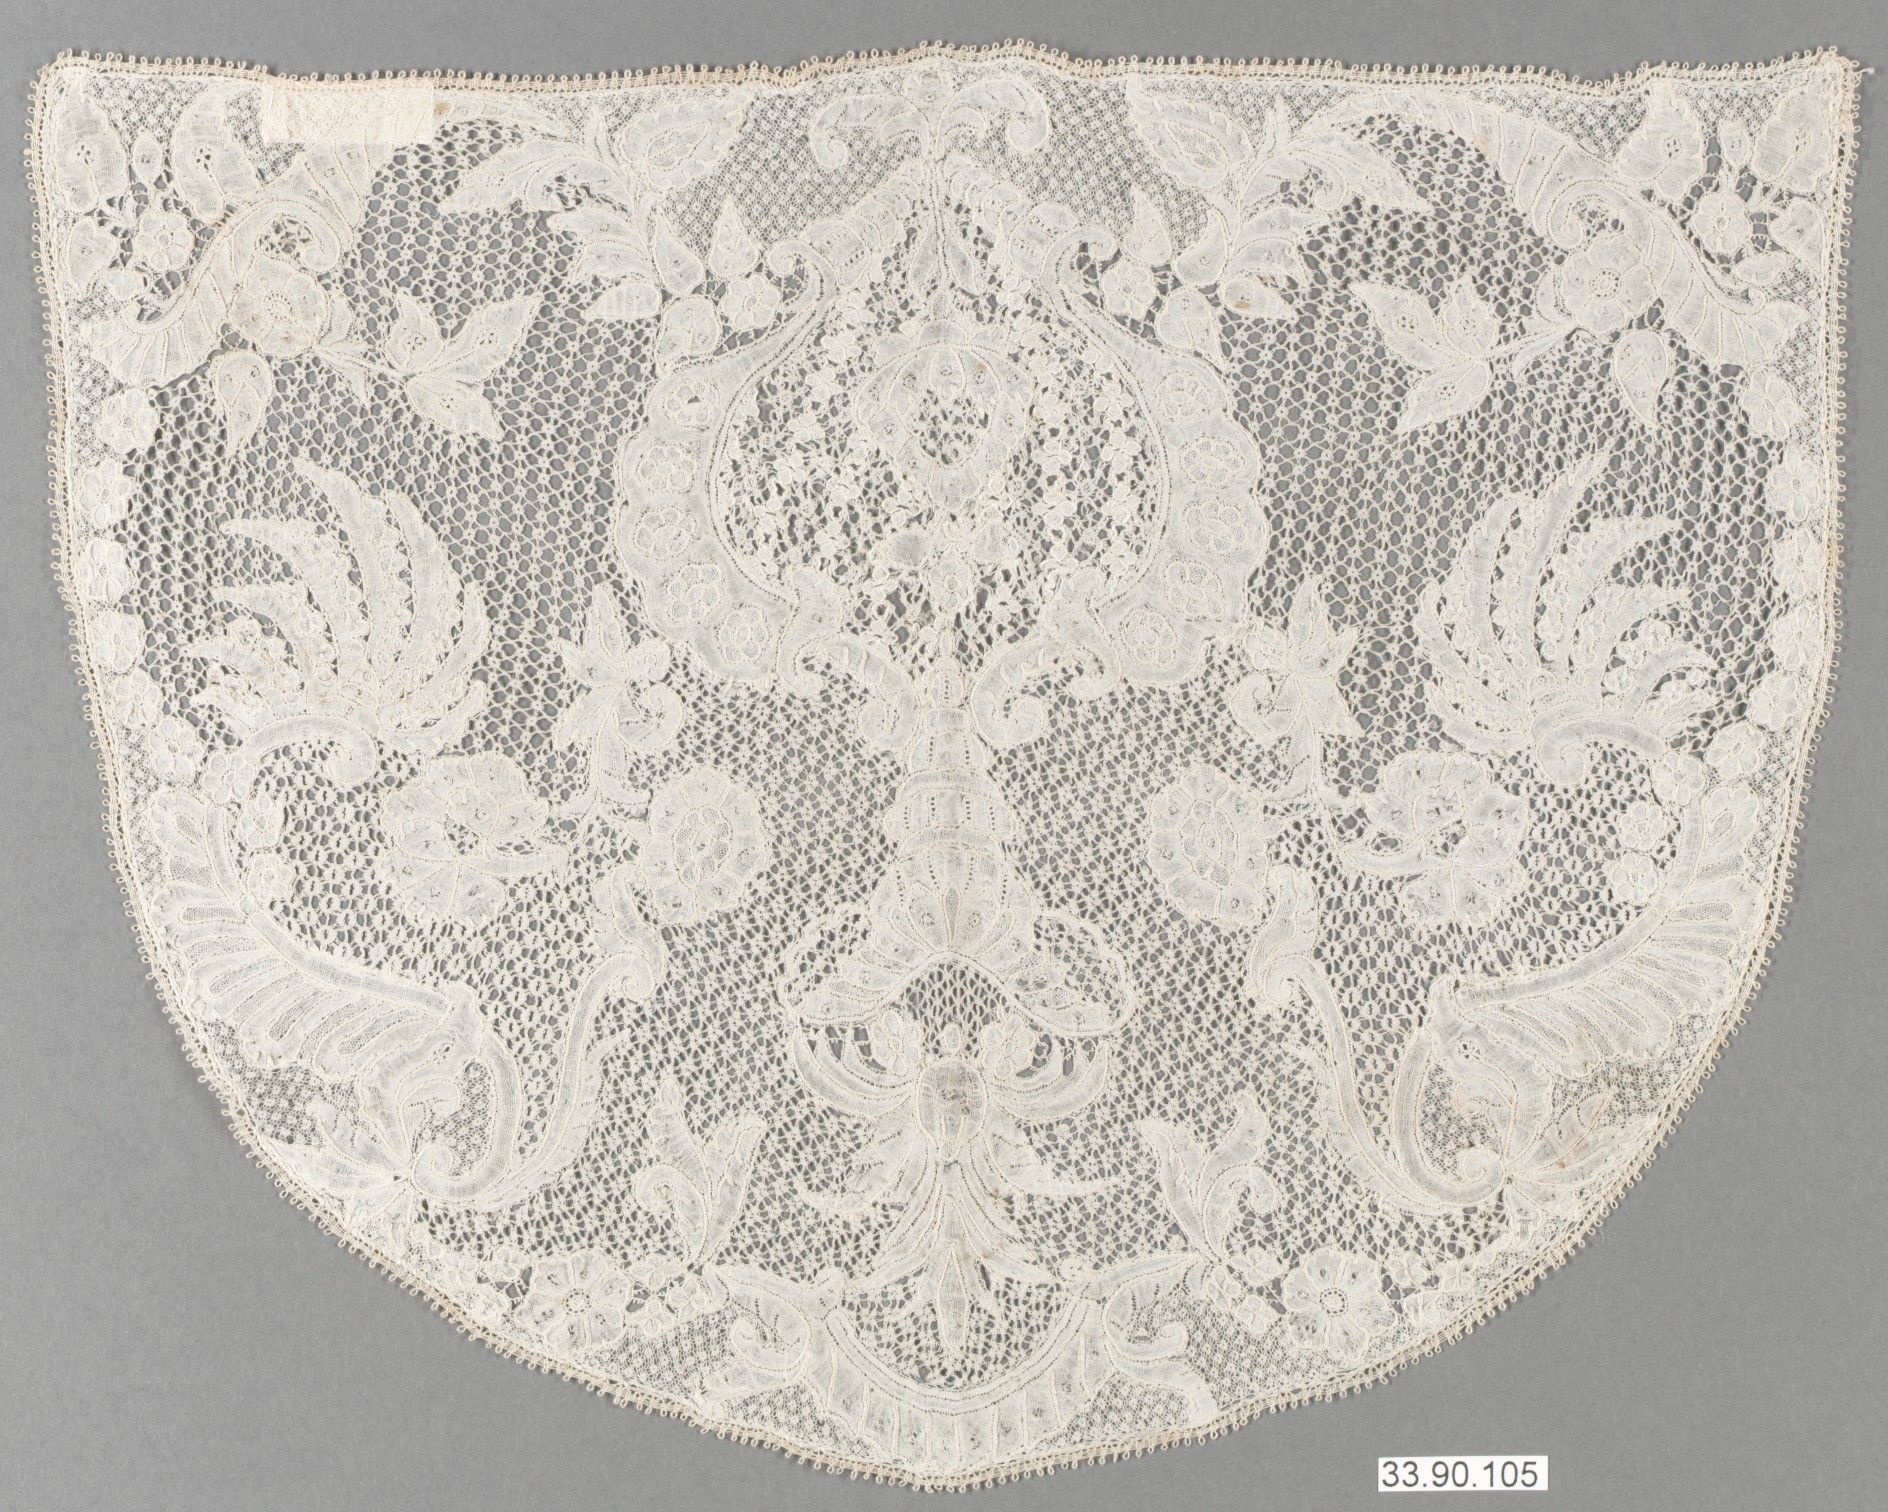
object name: cap crown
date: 1734-1766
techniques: lace